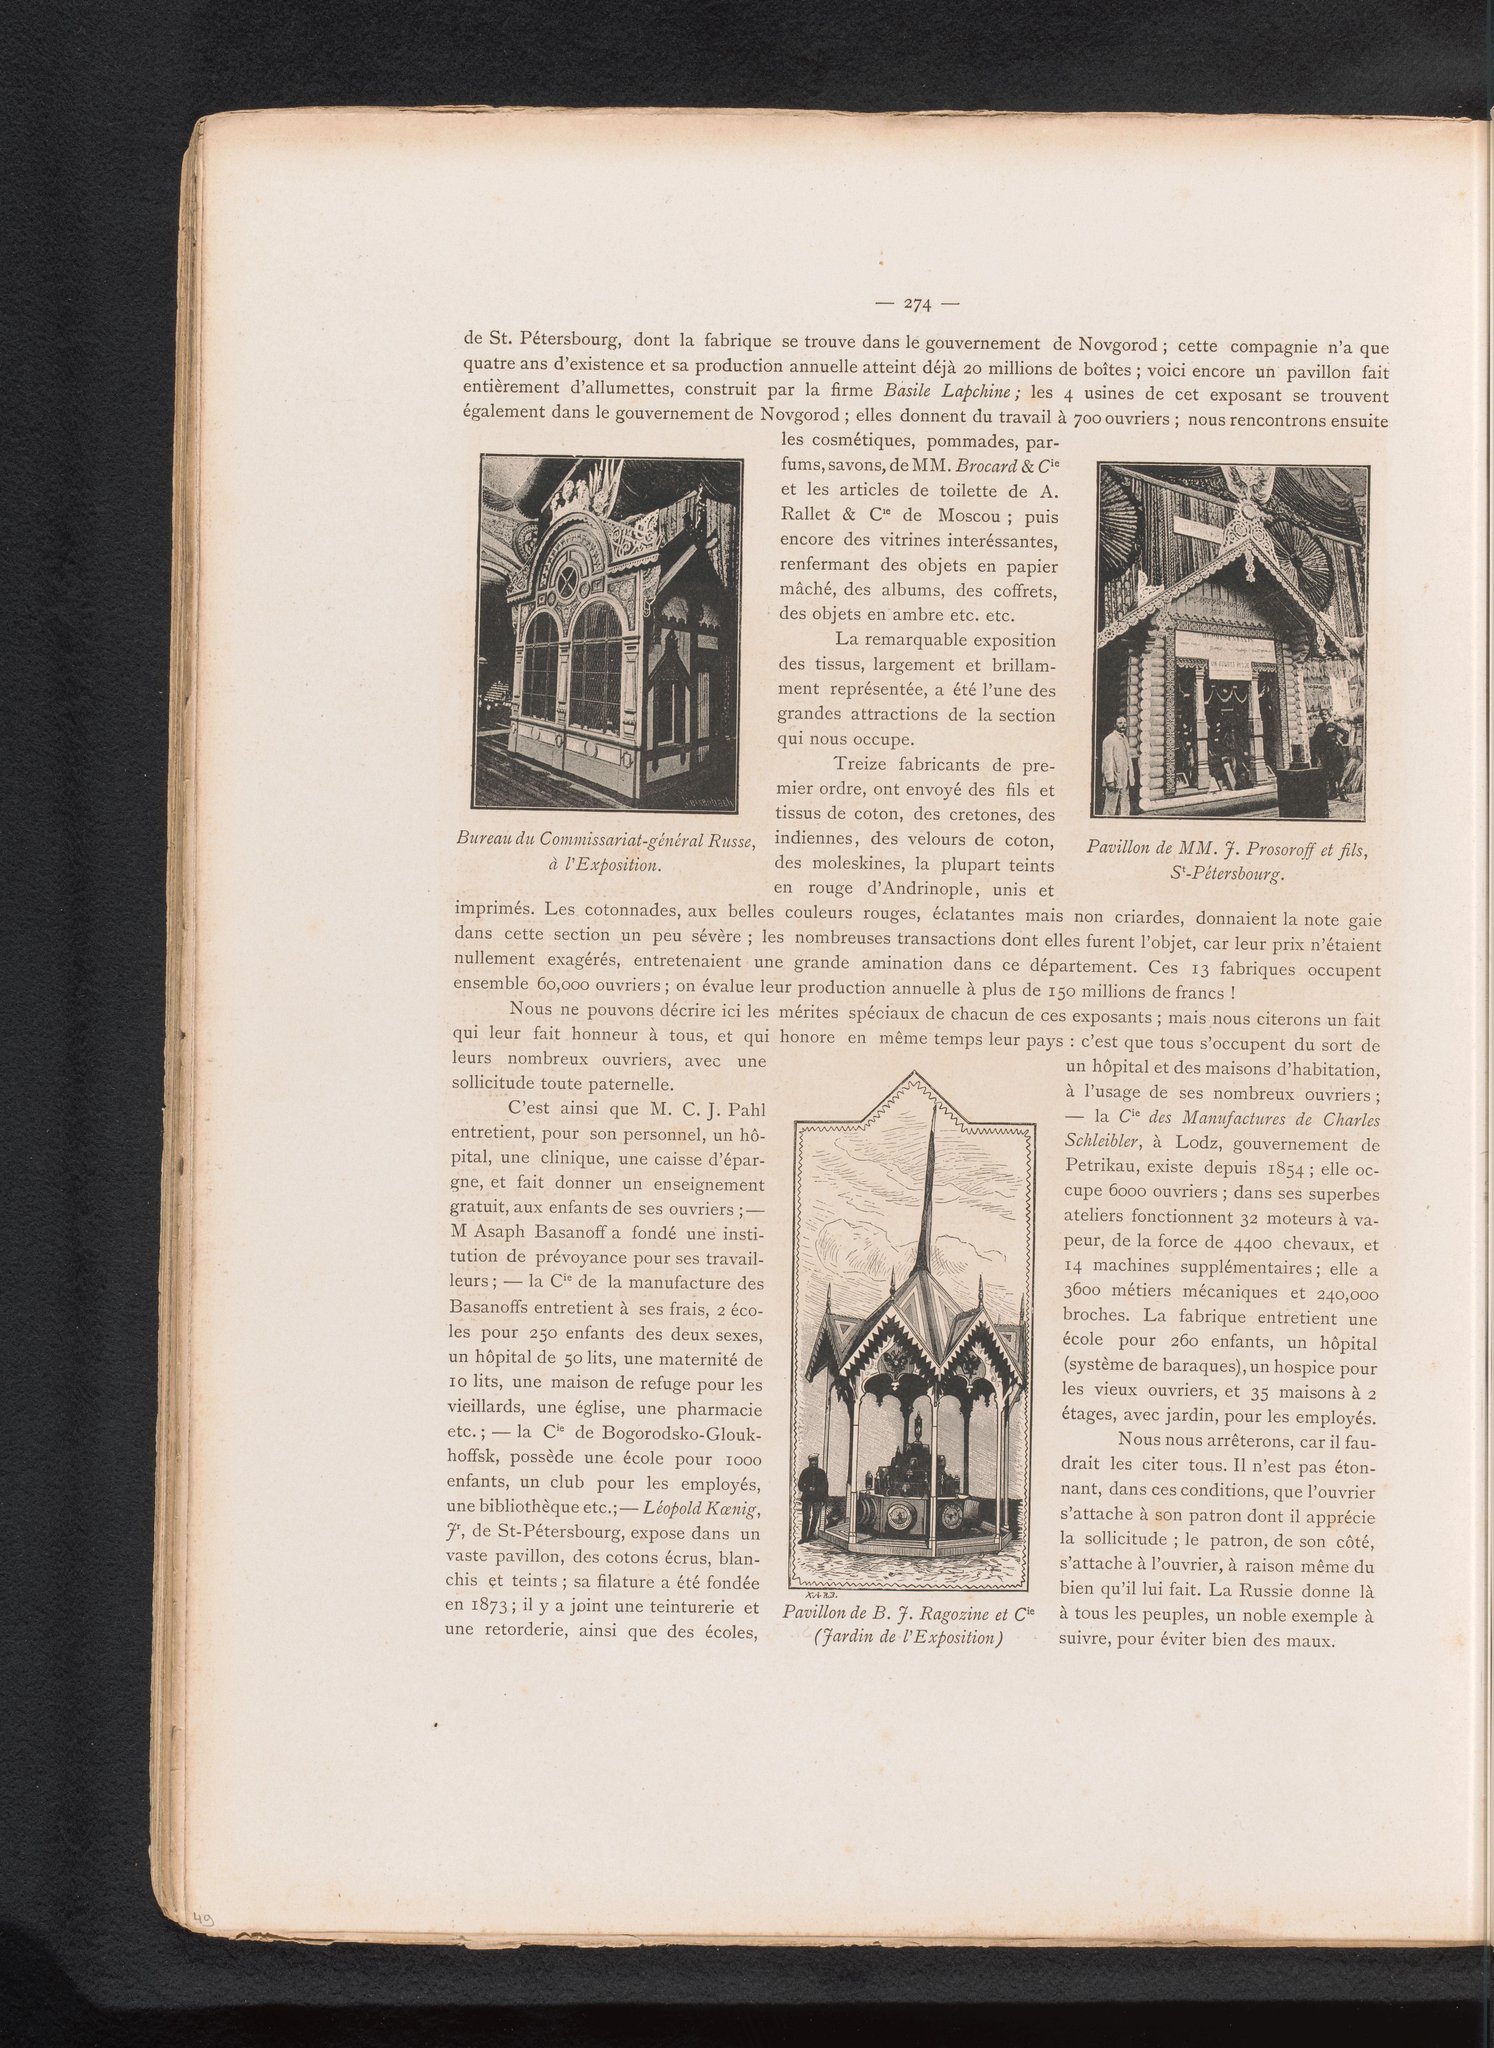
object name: page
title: Bureau du Commissariat-général Russe, a l'Exposition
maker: Anonymous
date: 1880-1885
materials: paper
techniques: autotype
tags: world fair, world exhibition, antwerp